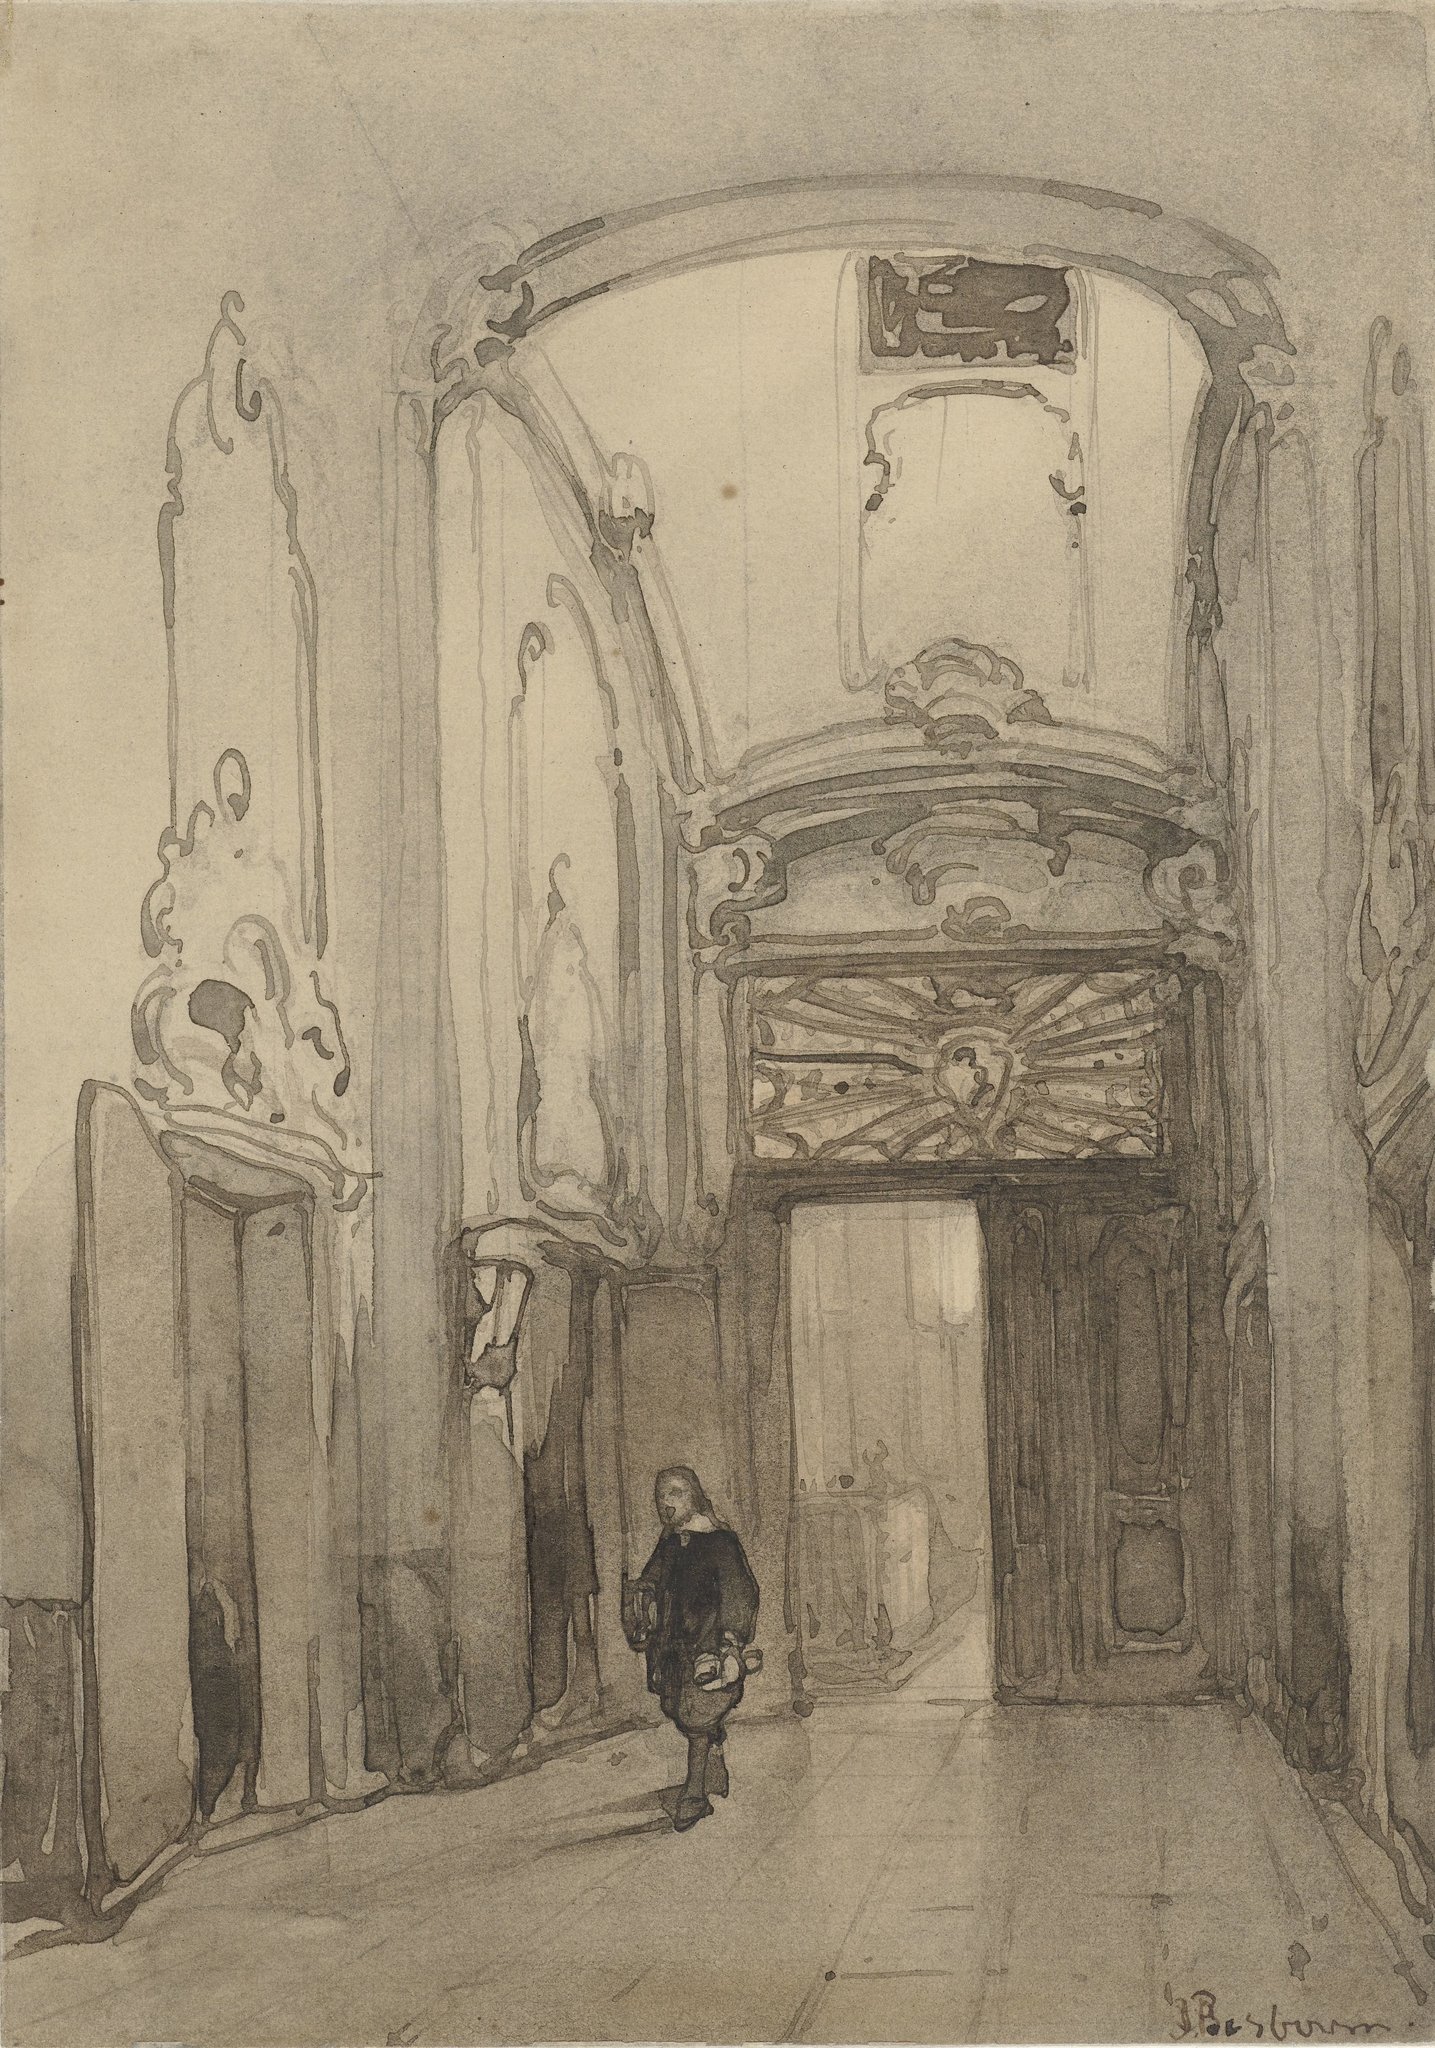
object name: drawing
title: Rococo portaal in het stadhuis in Den Haag met een man in zeventiende-eeuws kostuum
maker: johannes bosboom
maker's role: draughtsman, painter, print maker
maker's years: 1817-1891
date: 1827-1891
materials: ink, paper, pencil, watercolor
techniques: brush, pen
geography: netherlands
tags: townhall, interior of the house, the hague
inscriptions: signature: ‘J.Bosboom’